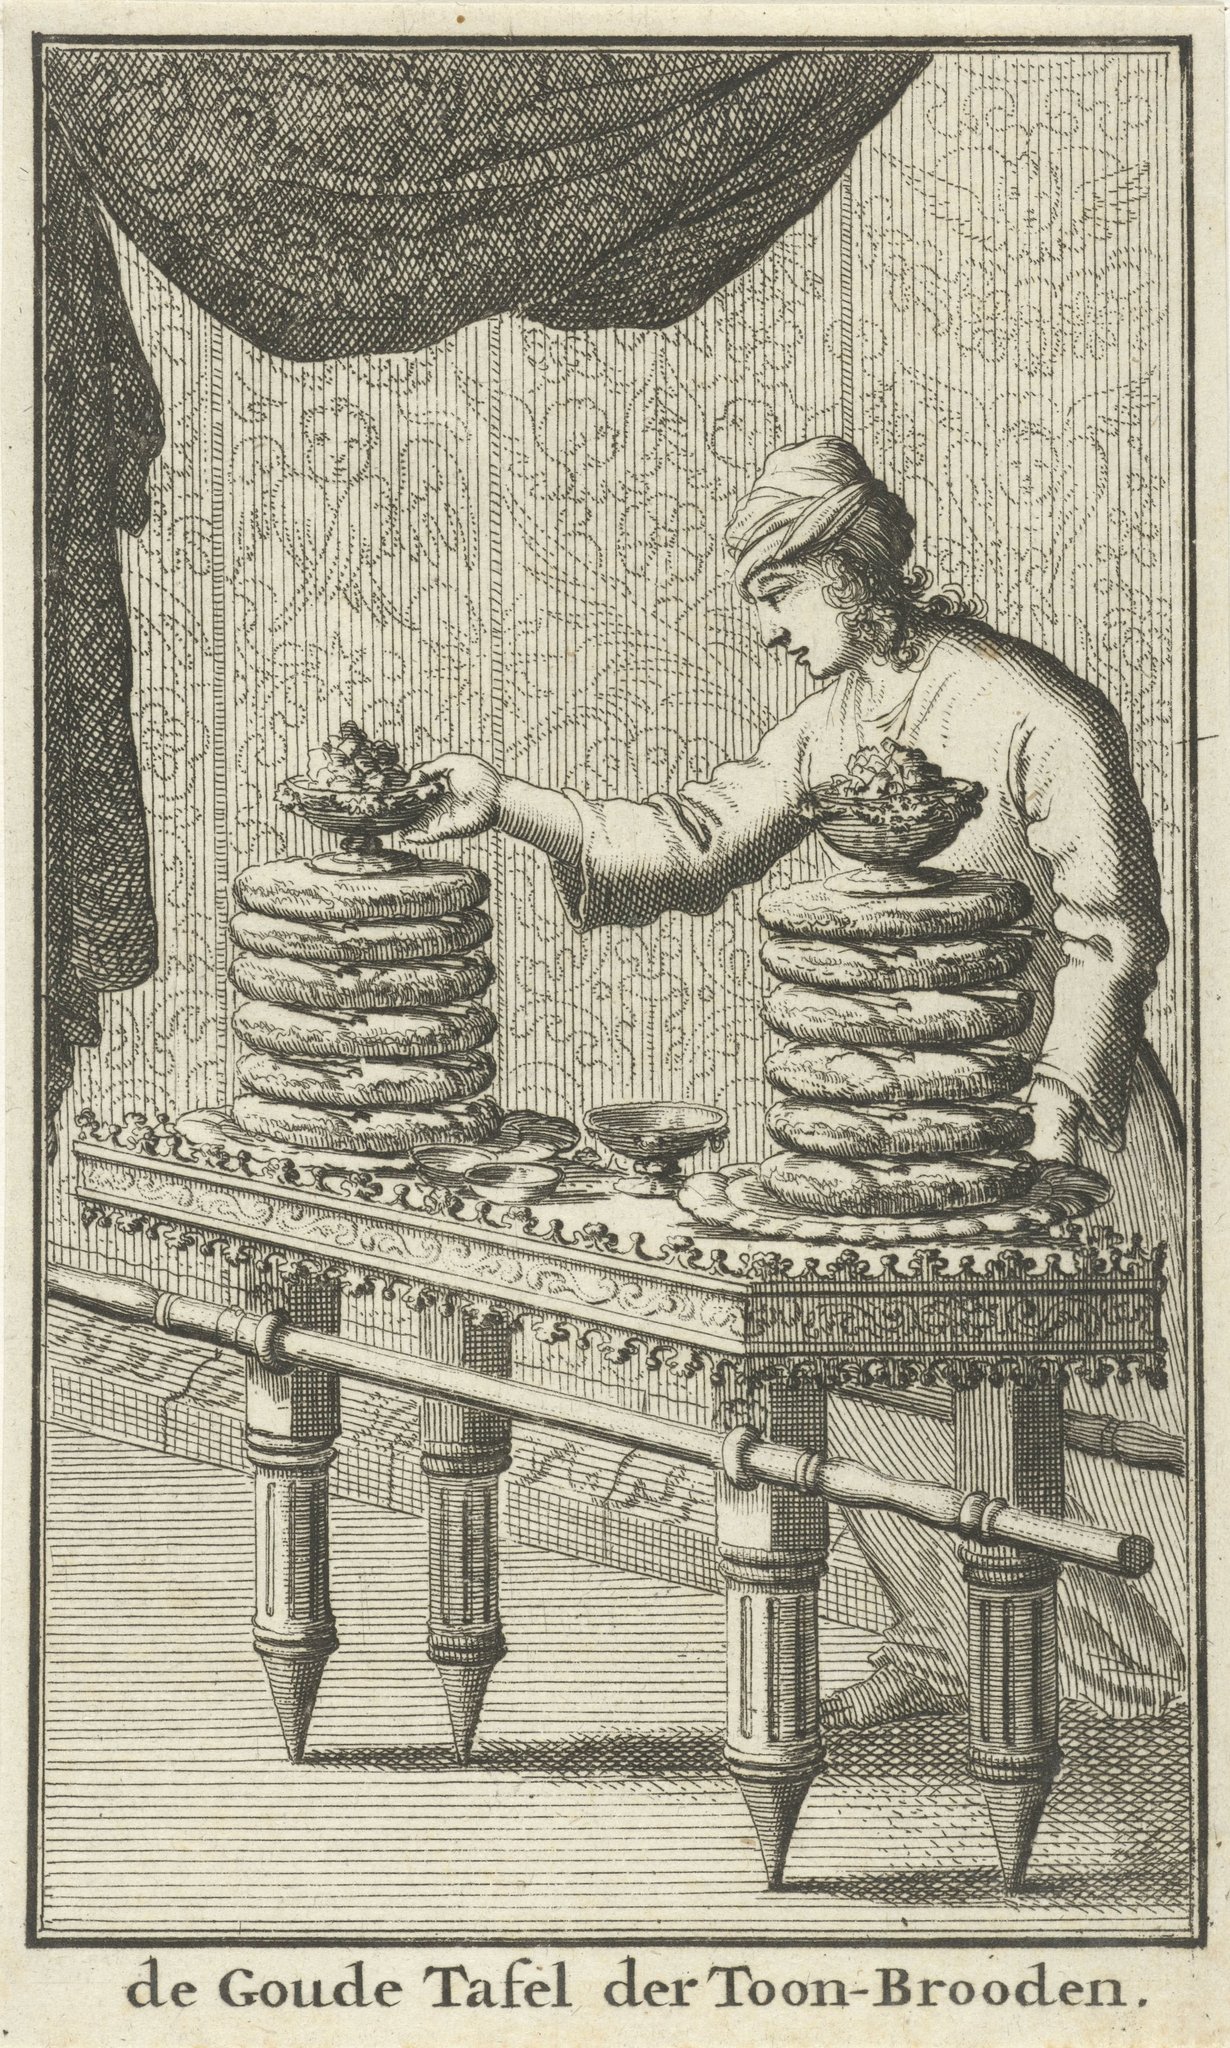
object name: book illustration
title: De Goude Tafel der Toon-Brooden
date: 1683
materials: paper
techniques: etching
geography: amsterdam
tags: table of the showbread in the tabernacle ~ jewish religion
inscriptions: collector's mark: Lugt 2228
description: Illustratie opgenomen in: Cunaeus, Petrus. De republyk der Hebreen, of gemeenebest der joden, 3 delen. Amsterdam: Wilhelmus Goeree, 1683, dl. 2, p. 326.